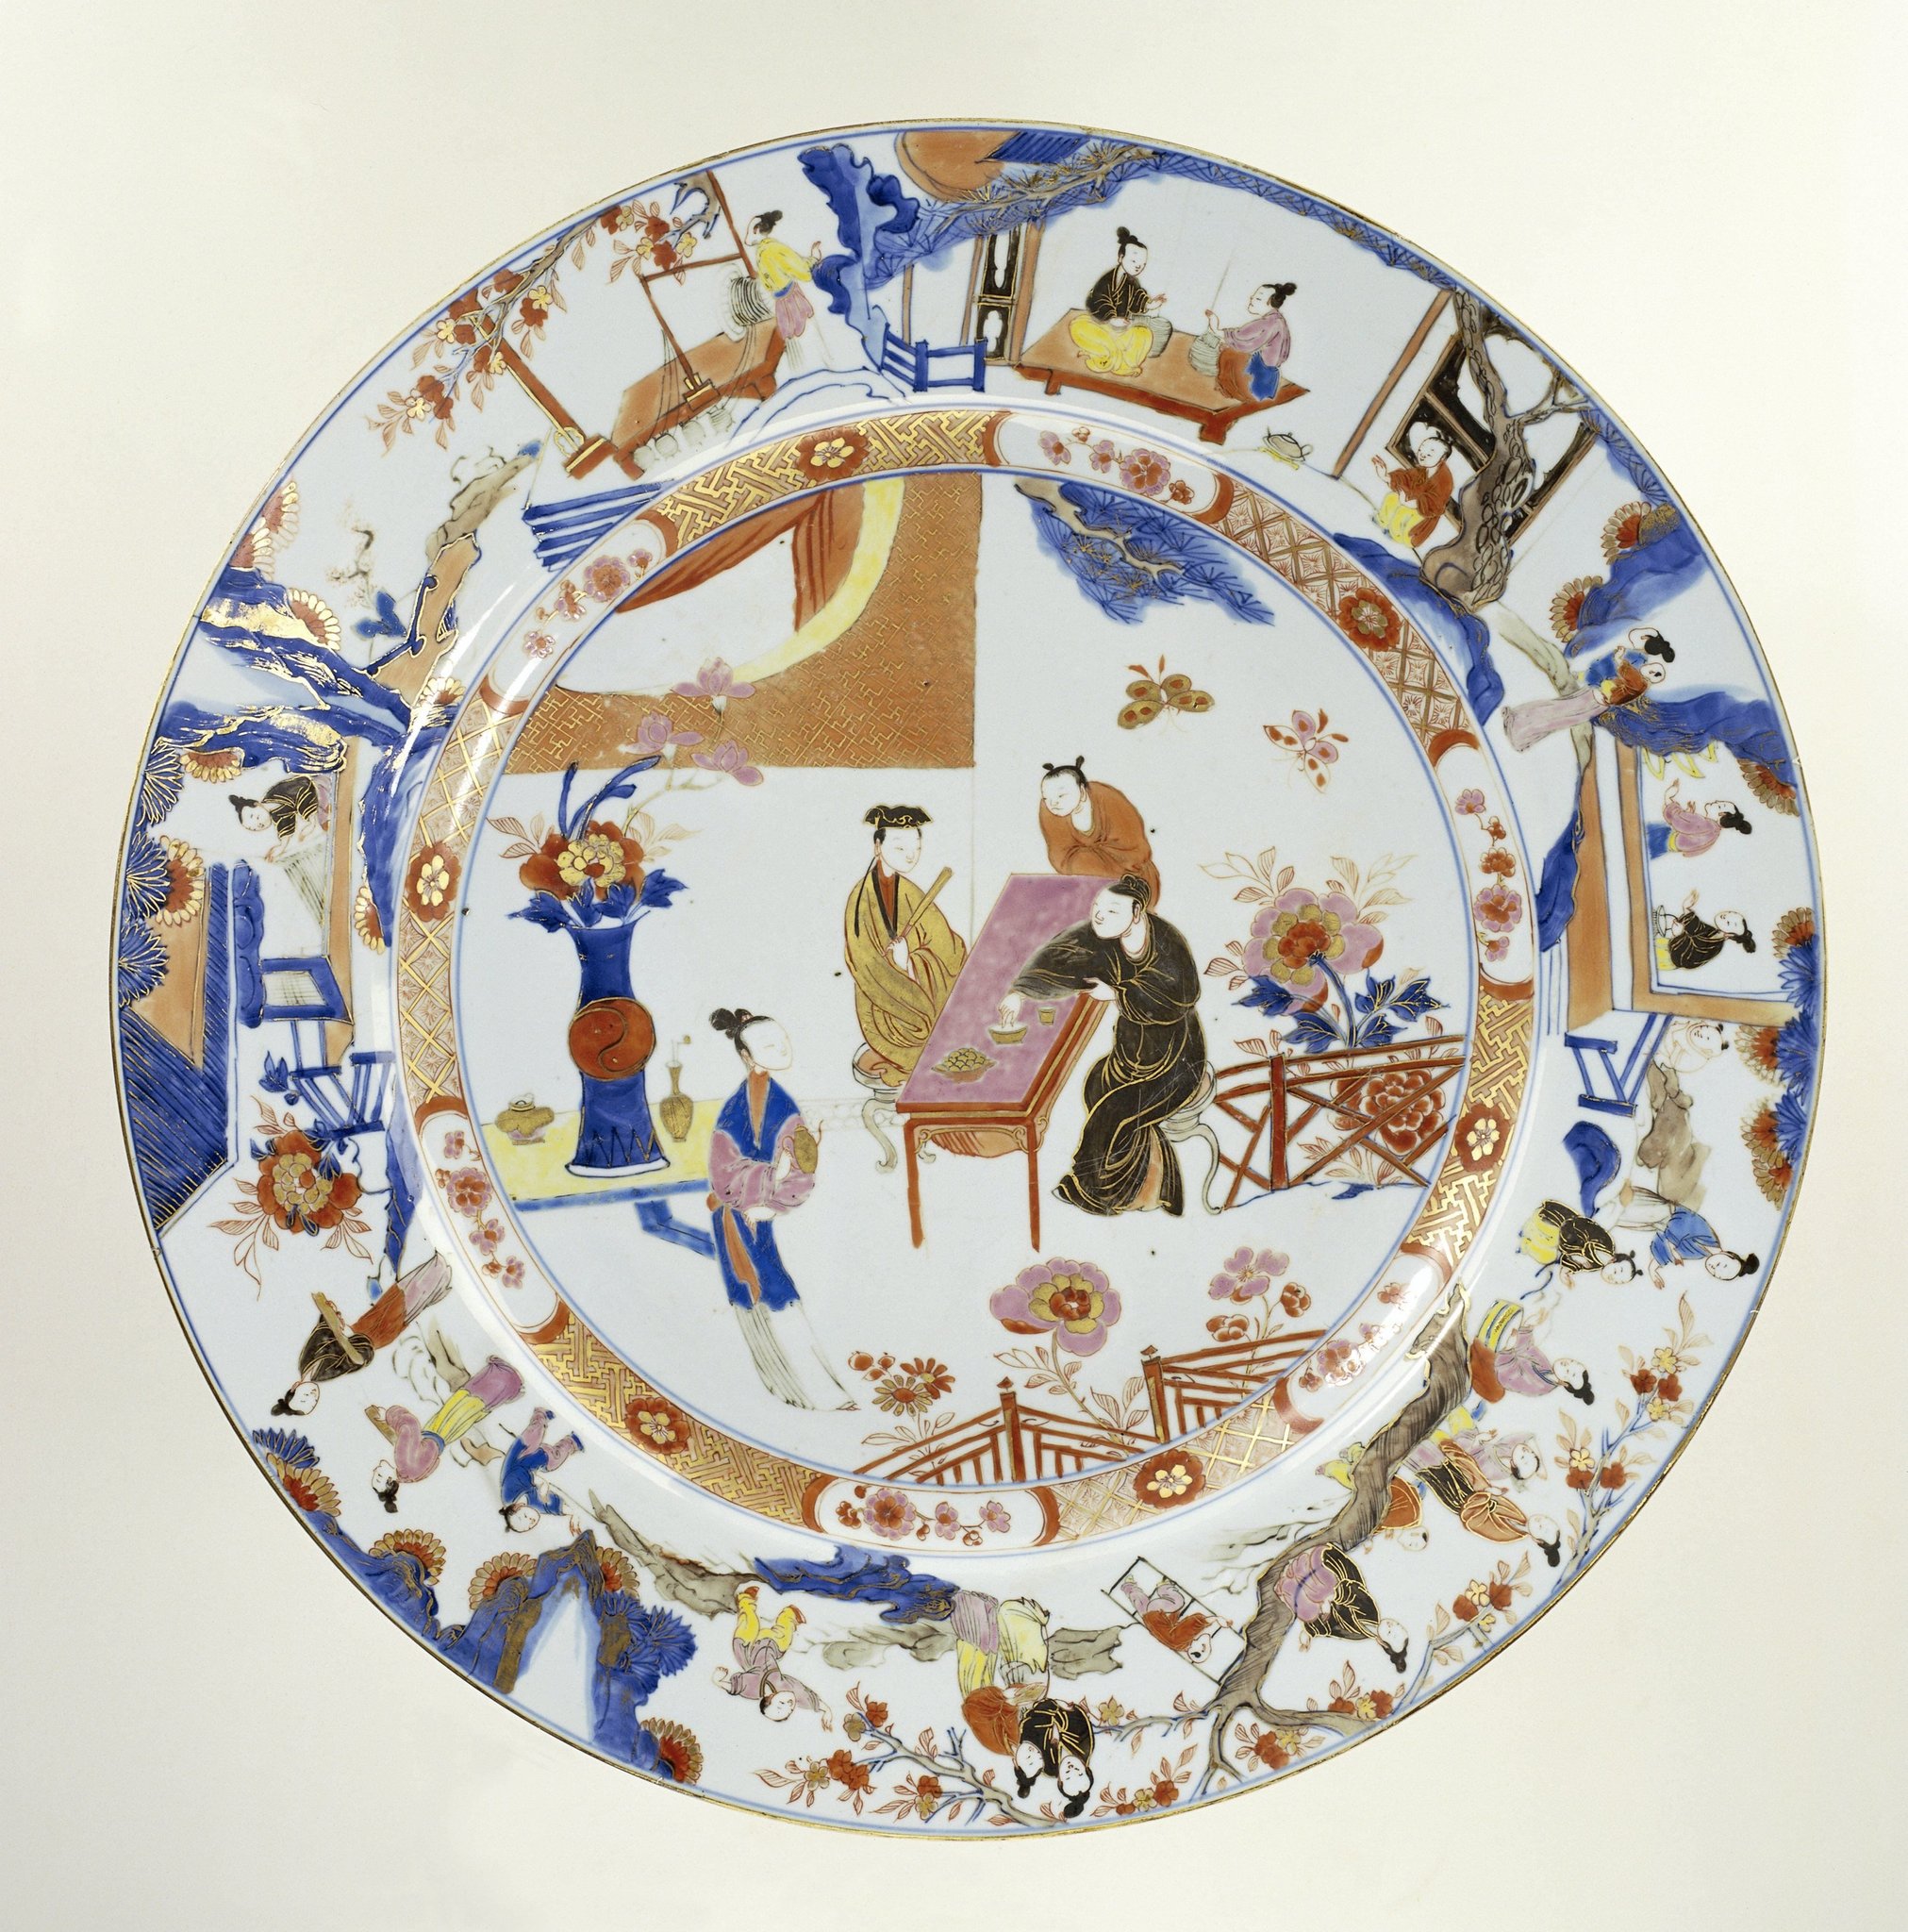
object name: platter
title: Dish with figures in a fenced garden near a pavilion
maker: Anonymous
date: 1725-1730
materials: cobalt, glaze, gold, paint, porcelain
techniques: firing, gilding, turning, vitrification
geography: china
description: The various stages of silk production are depicted on the rim of this dish. In the centre, three women are seated at a table and a fourth woman is standing, holding a pot of tea. This is an early example of a famille rose plate: porcelain painted with pink enamel. Famille rose became one of the most popular forms of porcelain imported to Europe in the later 18th century.